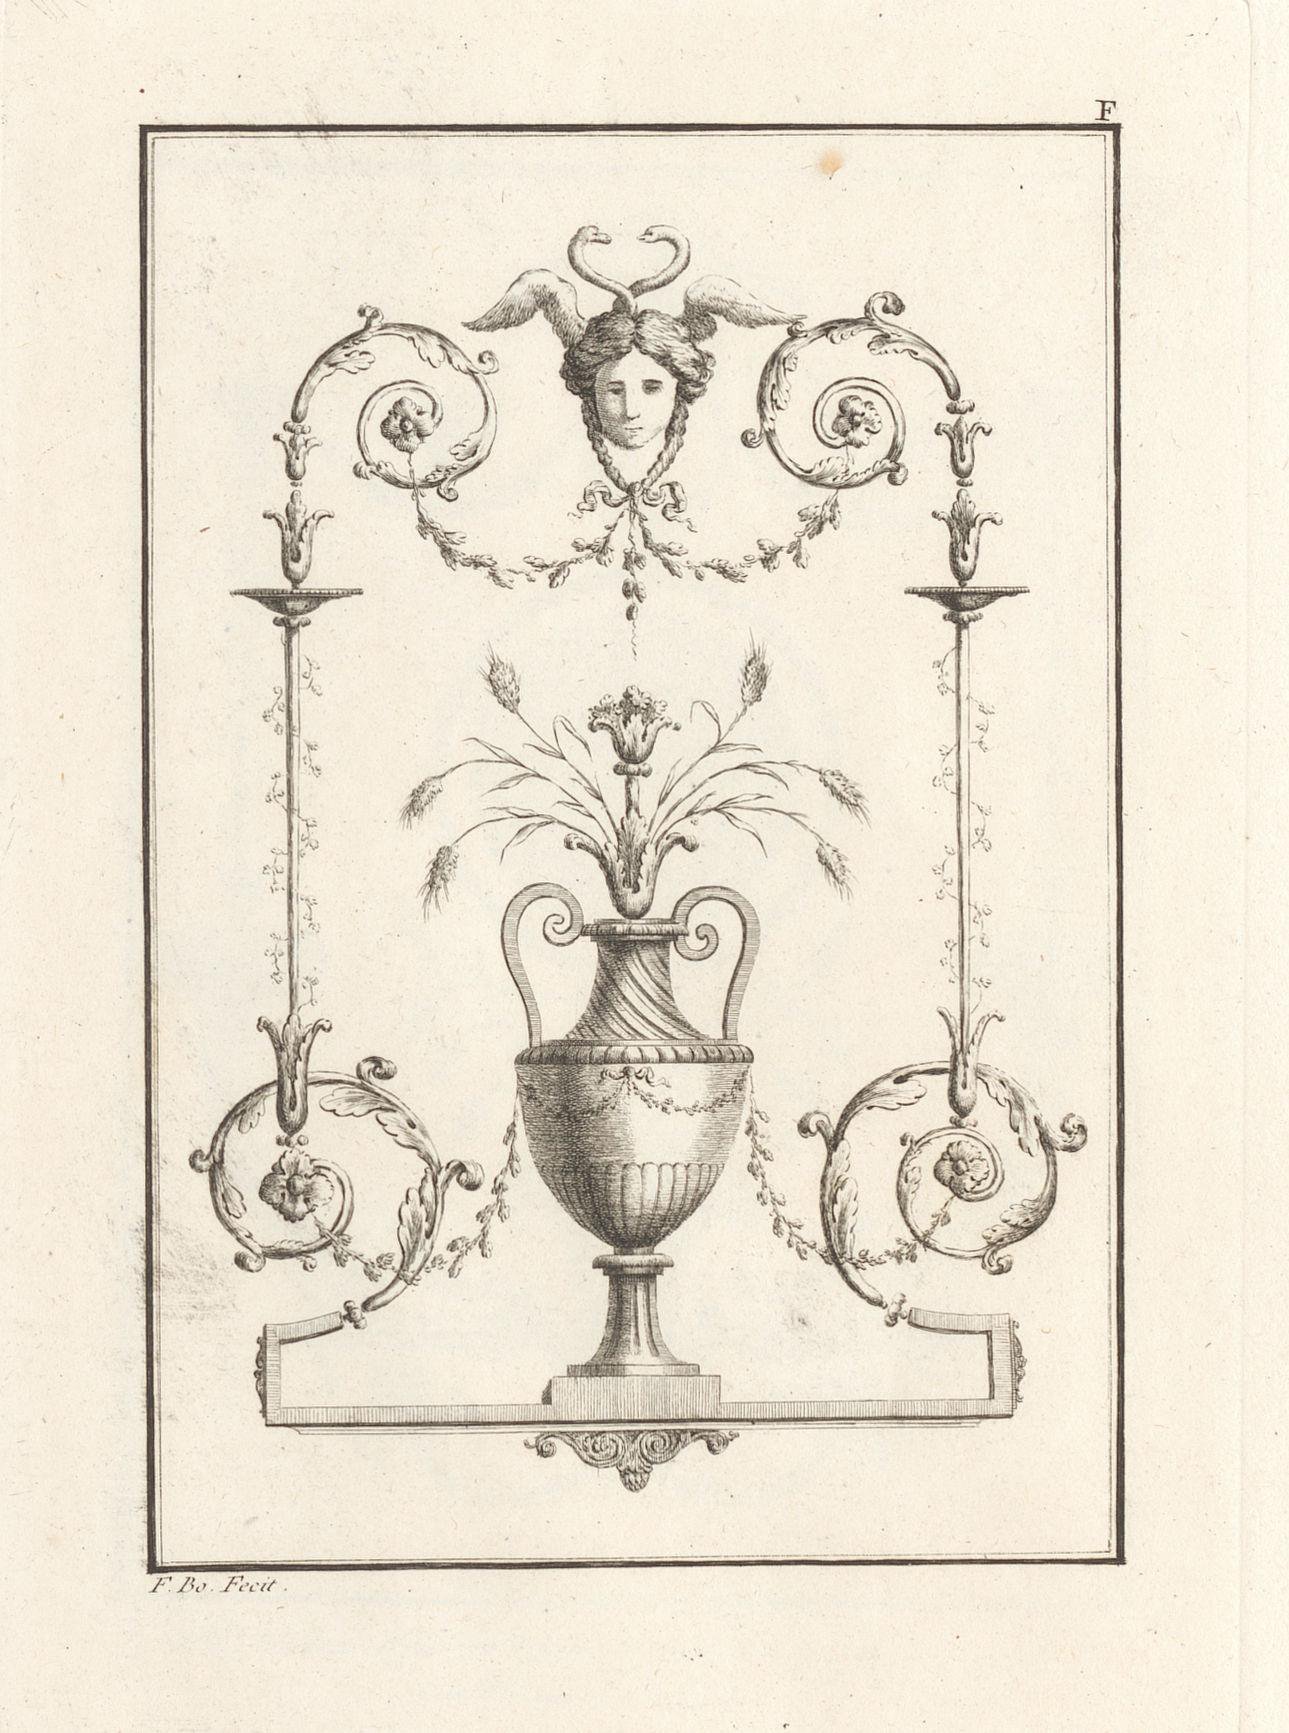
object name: ornament print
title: Arabesken, ontworpen door François Boucher, zesde serie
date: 1802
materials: paper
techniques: etching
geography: paris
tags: ornament ~ arabesque, vase ~ ornament, mask, mascaron ~ ornament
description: Doordat dit album bestaat uit meerdere, deels eerder uitgegeven prentreeksen, is de datering niet consequent. Het geheel is op de titelpagina gedateerd op 1802. Deze reeks is niet los gedateerd. De serietitel voor het gehele werk is "Recueil d'arabesques, contenant les loges du Vatican". De andere serietitel is de titel van de specifieke reeks binnen het geheel.